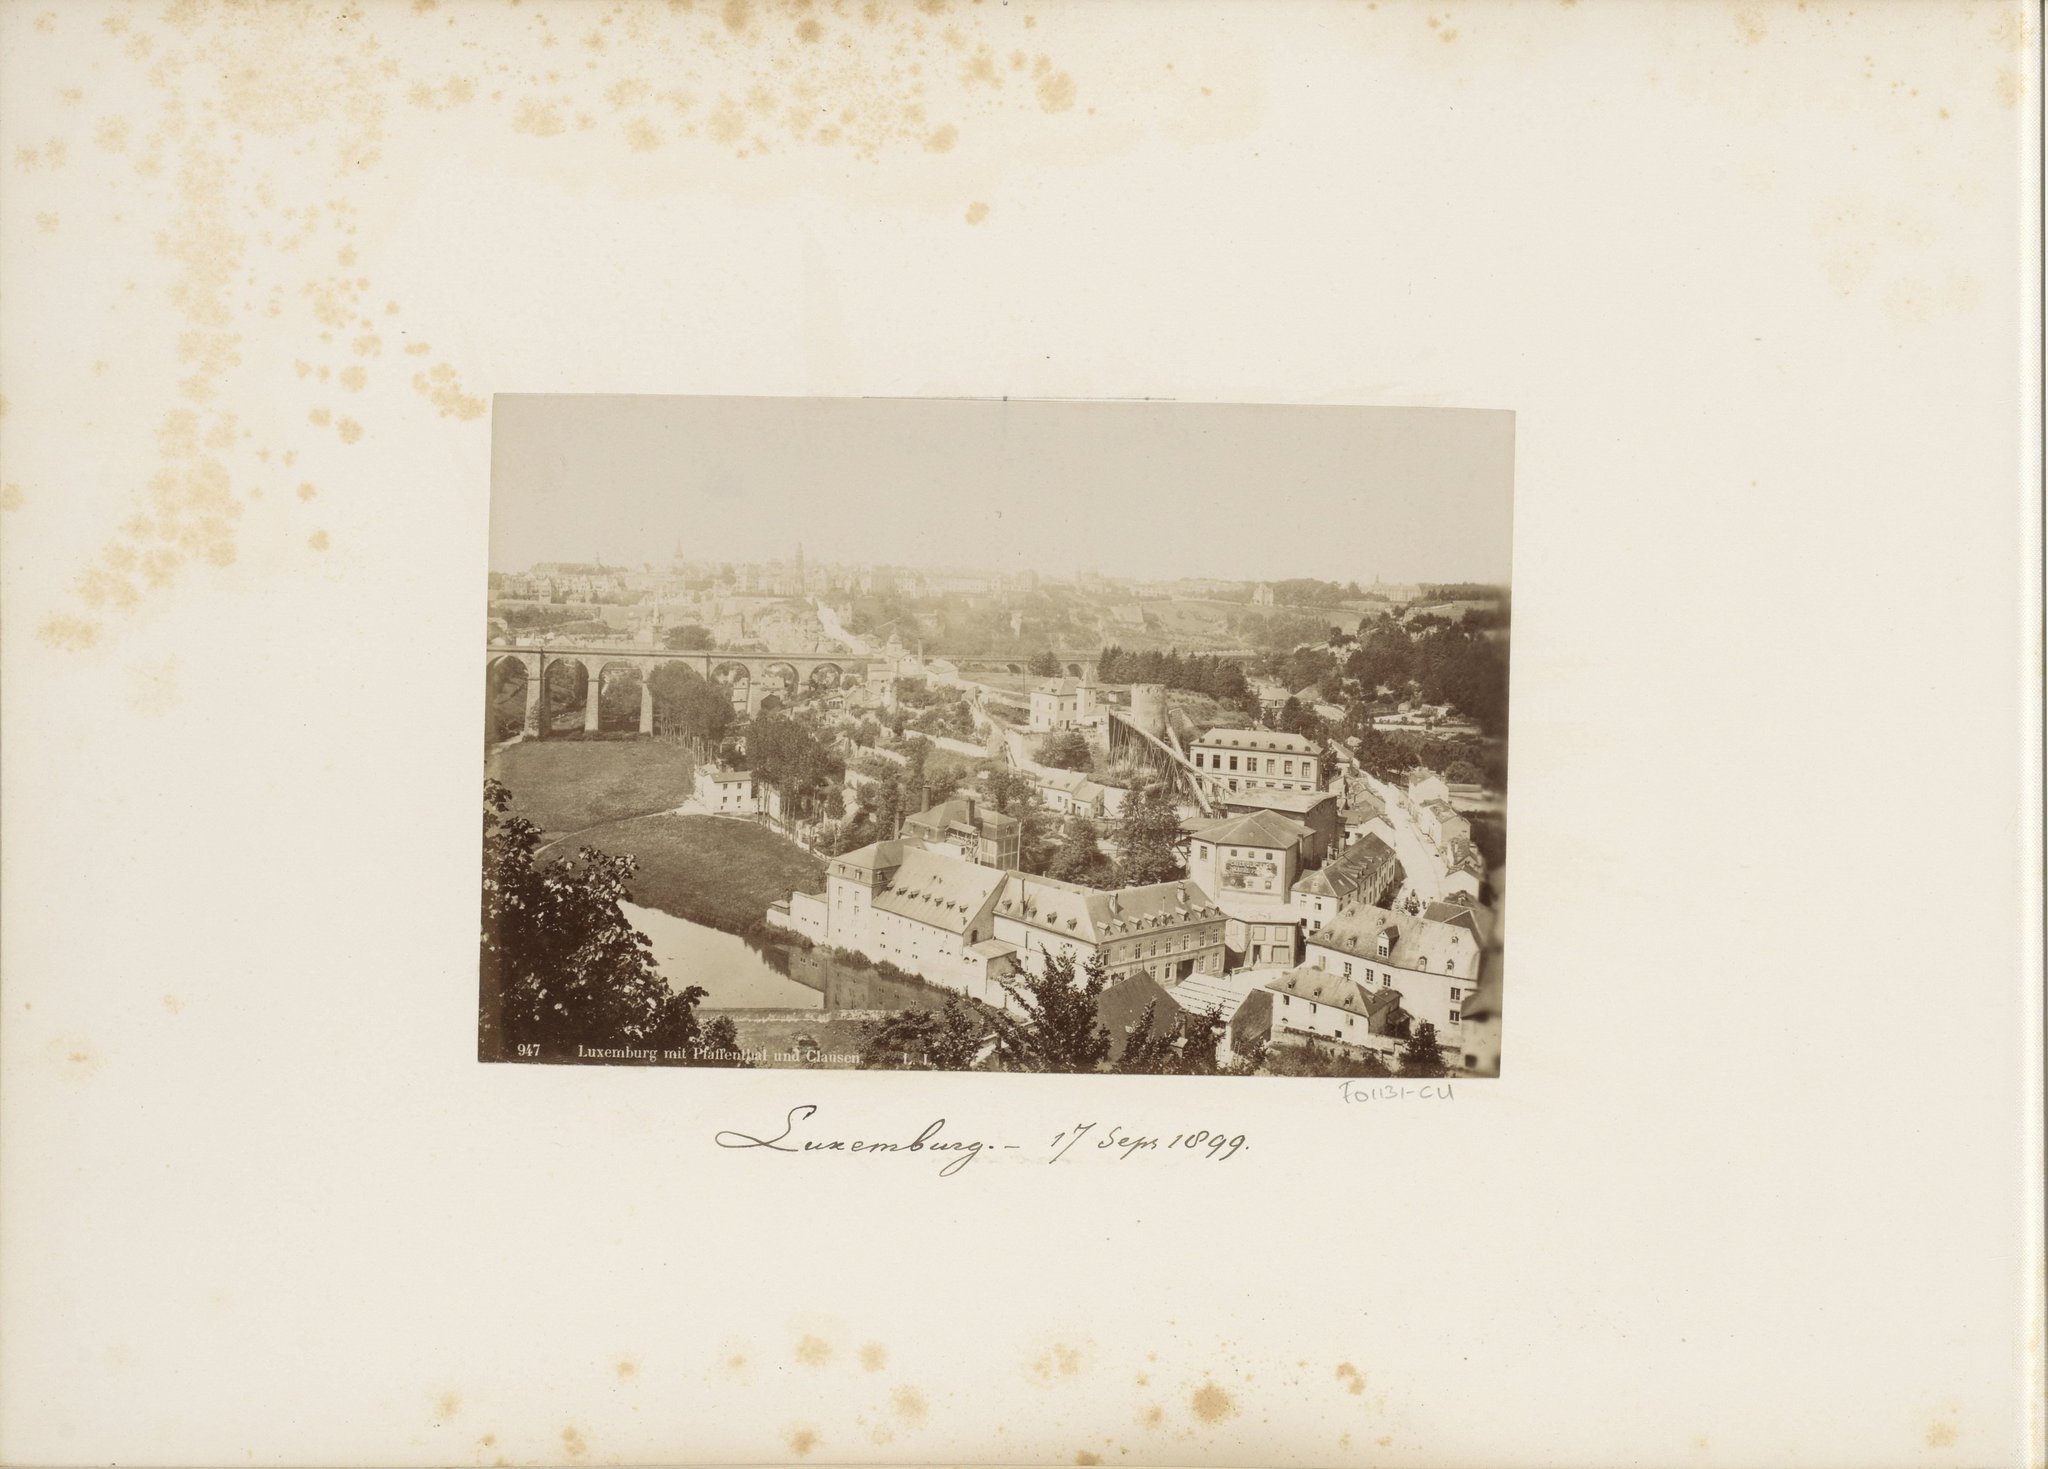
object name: album leaf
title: Luxemburg mit Pfaffenthal und Clausen.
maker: ll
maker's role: fotograaf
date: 1880-1899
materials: paper, photographic support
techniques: albumen print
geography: luxembourg city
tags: prospect of city, town panorama, silhouette of city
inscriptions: negative number: ‘947’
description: Onderdeel van Reisalbum met bezienswaardigheden in Duitsland, Oostenrijk, Zwitserland, Luxemburg en België.